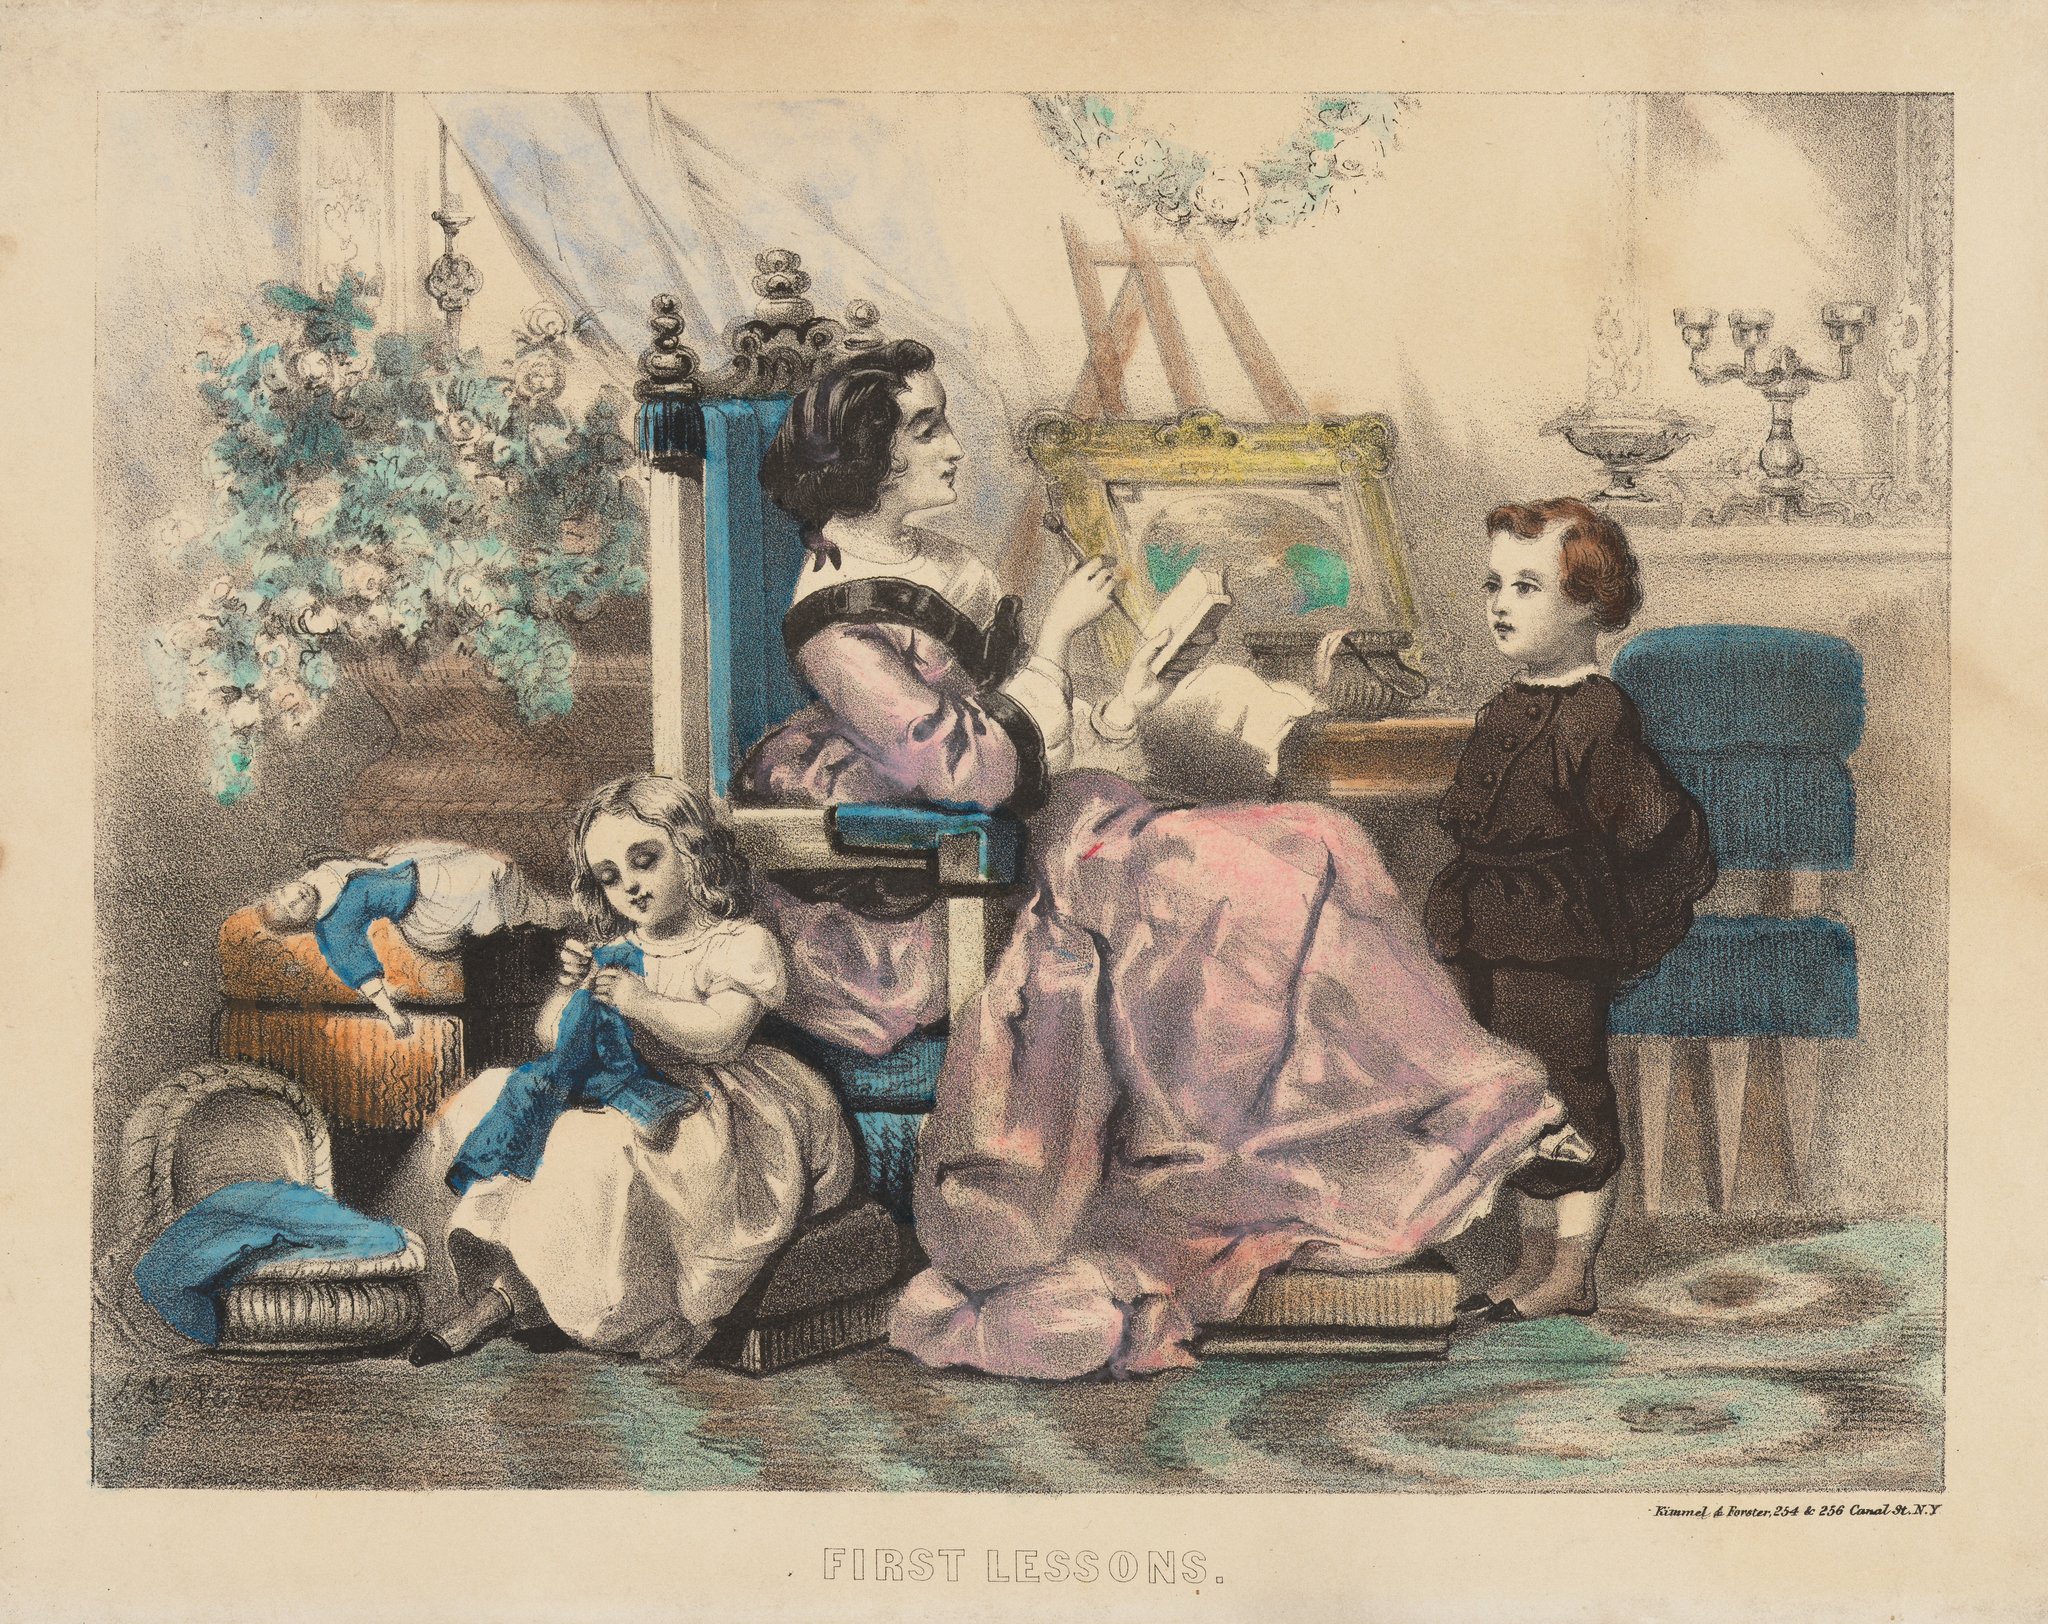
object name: print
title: First Lessons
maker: kimmel and forster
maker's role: publisher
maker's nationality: german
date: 1860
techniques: hand coloring, lithograph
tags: children,women,needlework